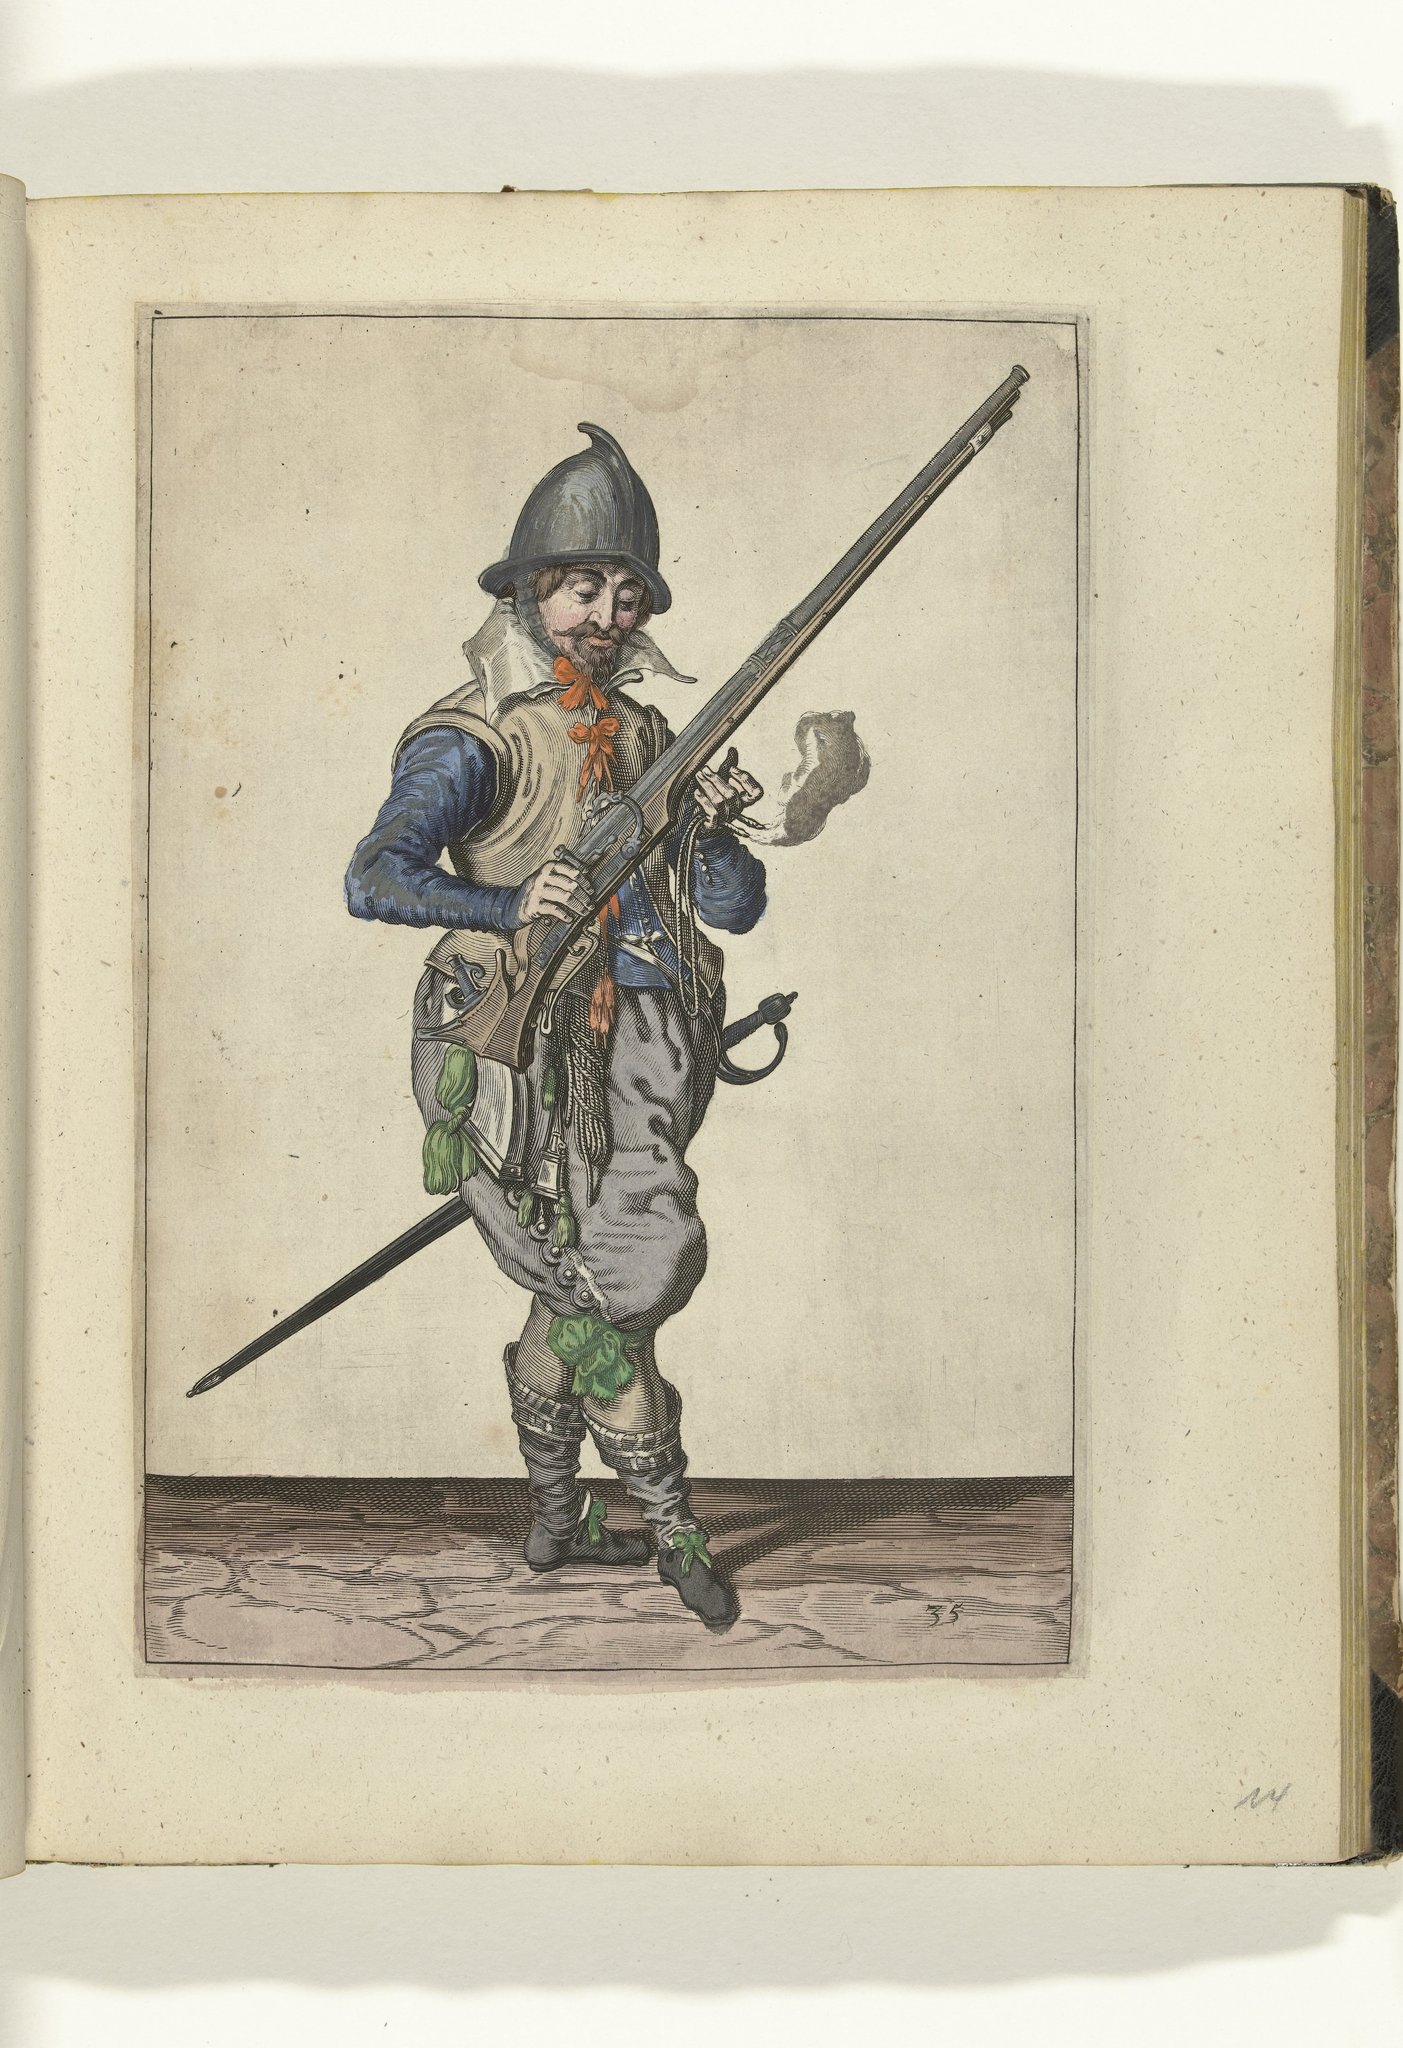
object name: print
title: Soldaat op wacht die zijn roer met zijn rechterhand schuin omhoog gericht vasthoudt, terwijl hij de loop in zijn linkerhand laat vallen (nr. 35), ca. 1600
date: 1597-1608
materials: paper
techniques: engraving, hand coloring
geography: northern netherlands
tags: maurice (prince of orange), handling of weapons ~ military training, weapons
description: Een soldaat op wacht, ten voeten uit, naar rechts, die een roer (een bepaald type vuurwapen) met zijn rechterhand vasthoudt, de loop schuin omhoog gericht (nr. 35), ca. 1600. Hij laat de loop juist in zijn linkerhand vallen, waarin ook een brandende lont. Plaat 35 in de instructies voor het hanteren van de roer: Shorte instruction upon the contrefaictinges, touching the right use of calivers. Onderdeel van de illustraties in een Engelse editie van J. de Gheyns Wapenhandelinghe: J. de Gheyn, The exercise of armes for calivres, muskettes and pikes after the ordre of Maurits Prince of Orange, 's-Gravenhage 1608. Krijgswezen rond 1600.